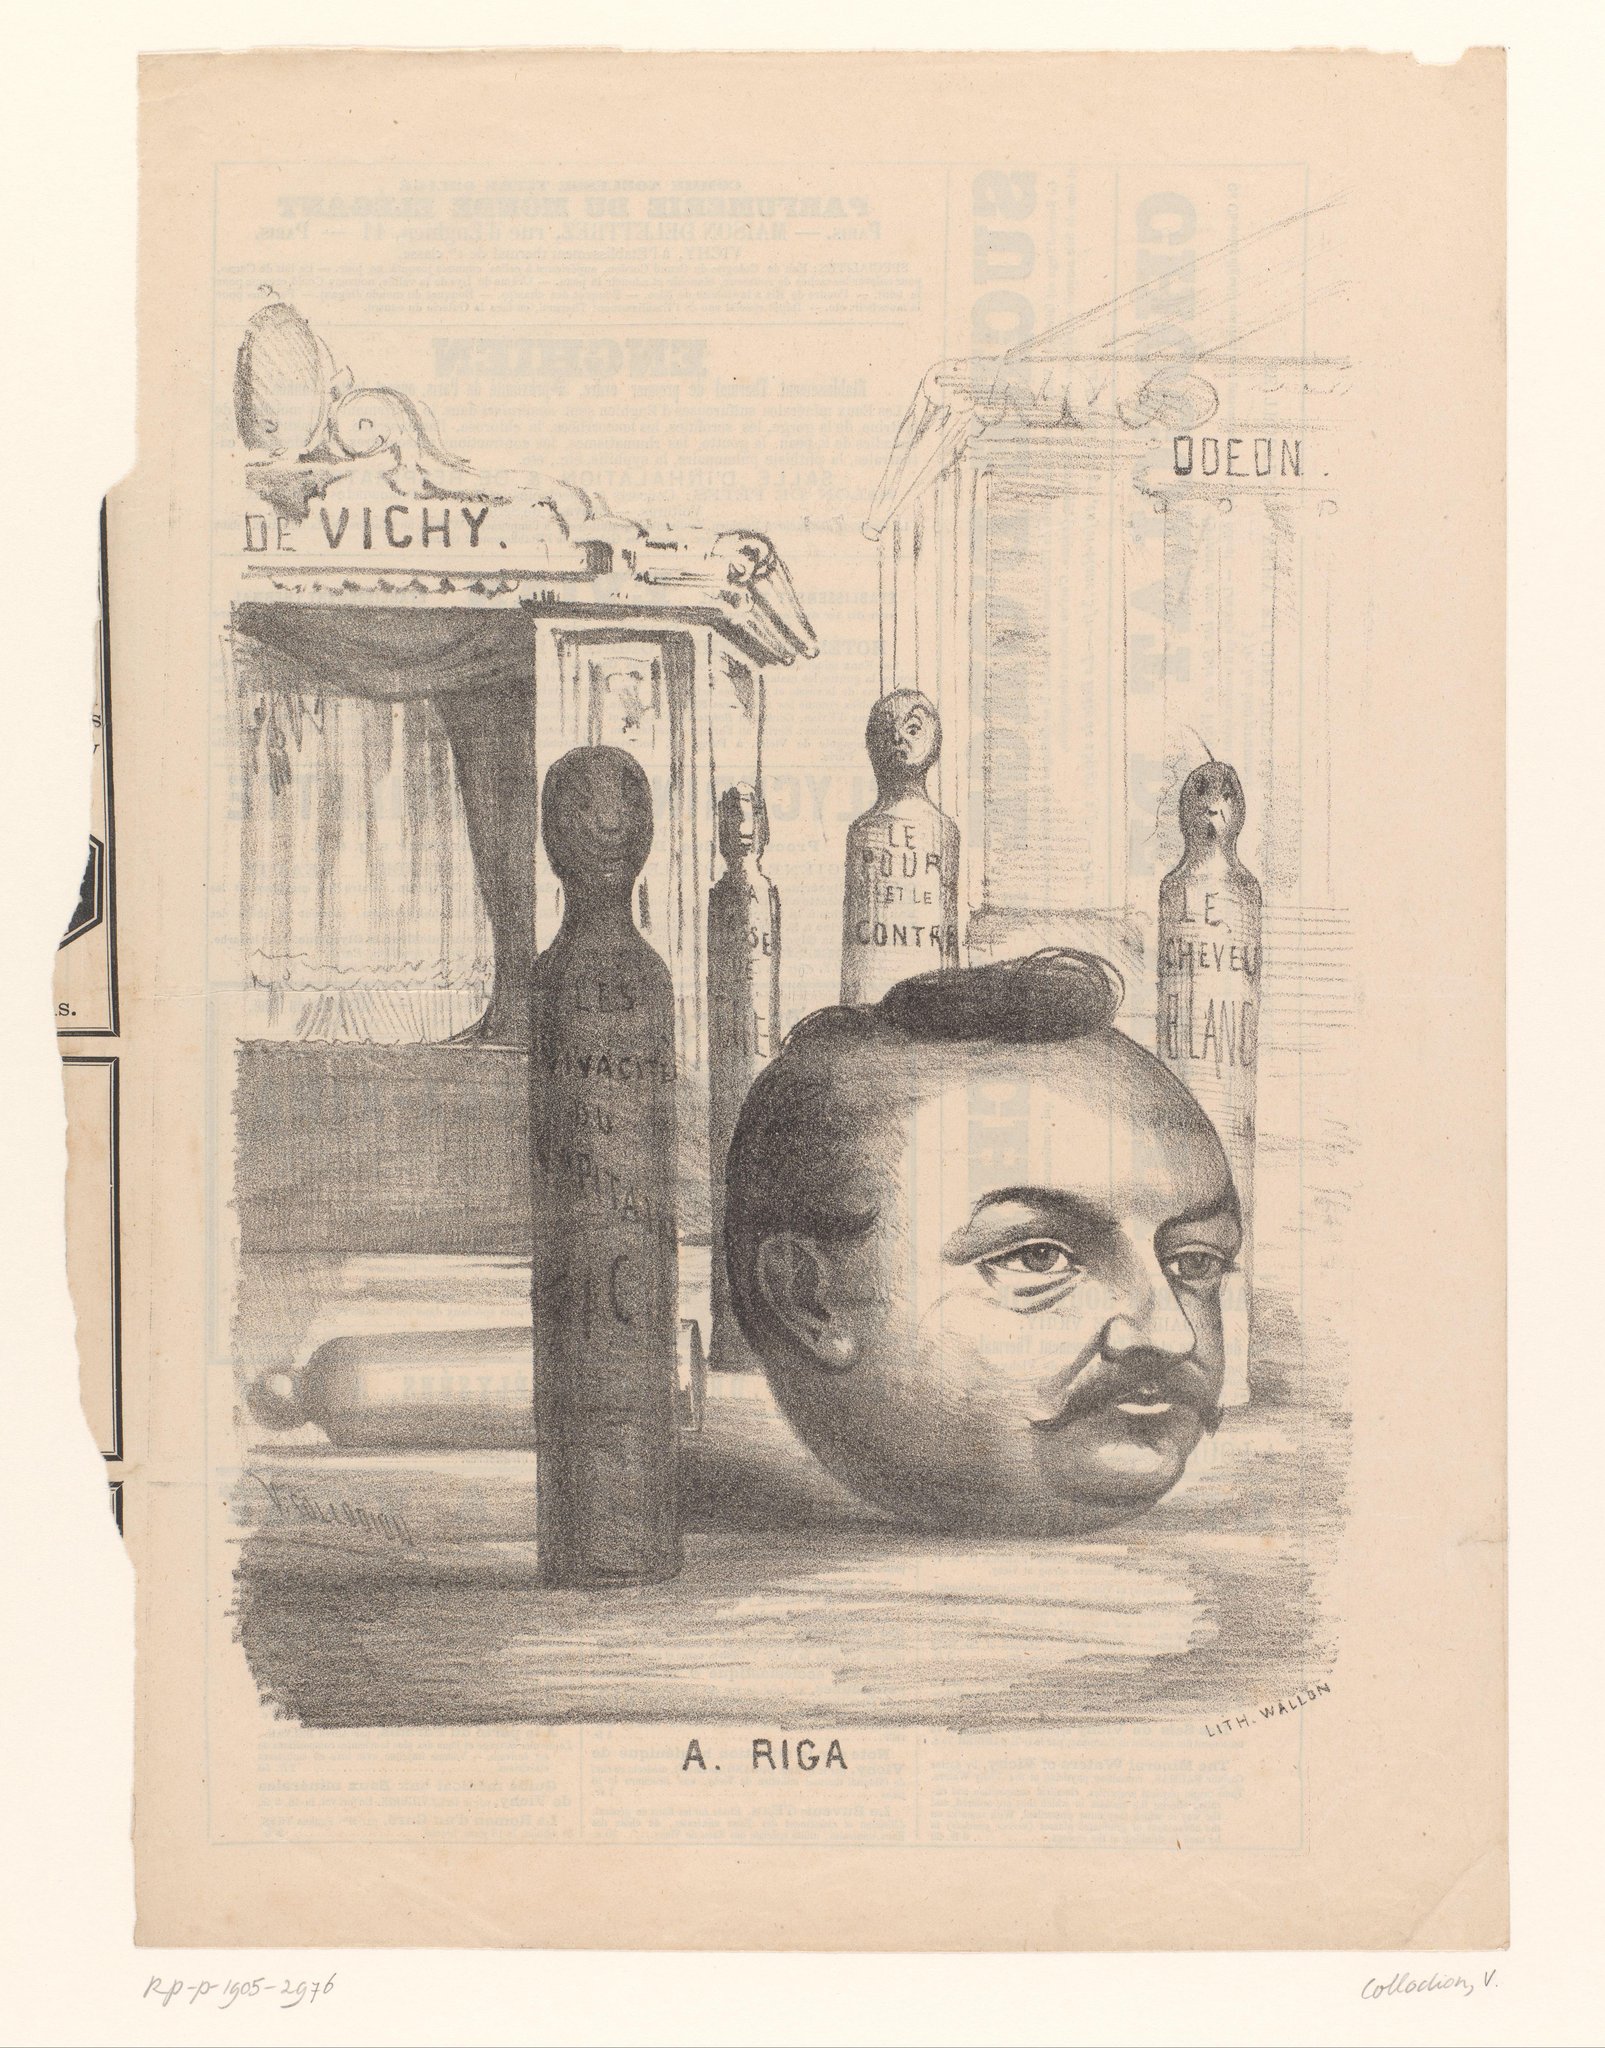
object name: print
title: Karikatuur van A. Riga bij het theater van Vichy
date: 1866-1870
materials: paper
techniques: lithograph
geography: vichy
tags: caricatures (human types), historical persons, theatre (building)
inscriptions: collector's mark: Lugt 2228a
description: Prent gepubliceerd in: Le Programme de Vichy, 1866-1870.